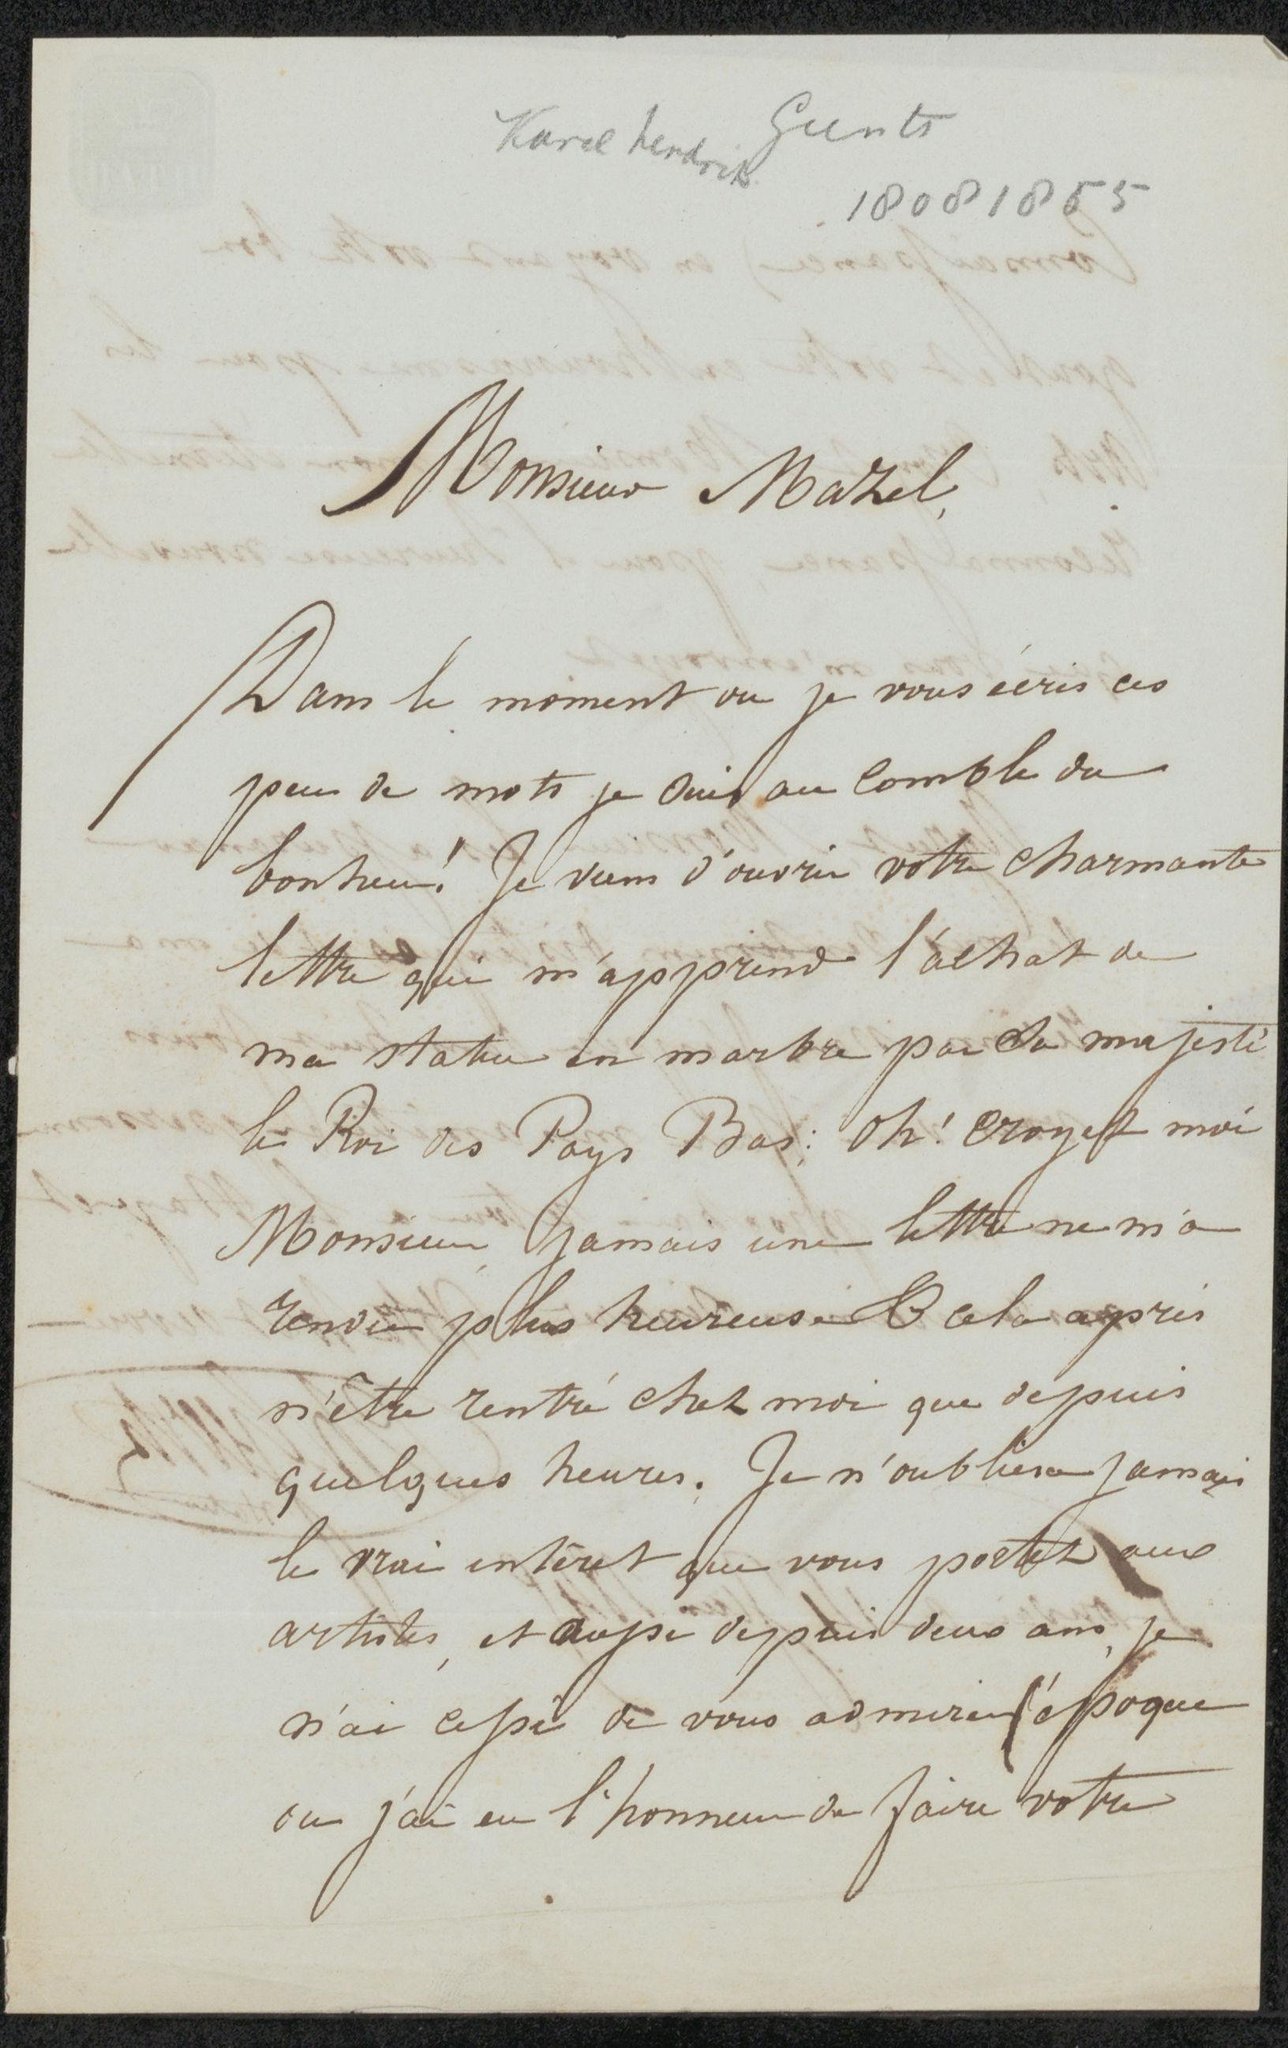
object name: letter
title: Brief aan Jean Zacharie Mazel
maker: karel-hendrik geerts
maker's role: sculptor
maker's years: 1807-1885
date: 1845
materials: ink, paper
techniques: pen, writing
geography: leuven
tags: william ii of the netherlands, the hague, draughtsman, politician, passions, emotions, affections, sculpture, art collecting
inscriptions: seal